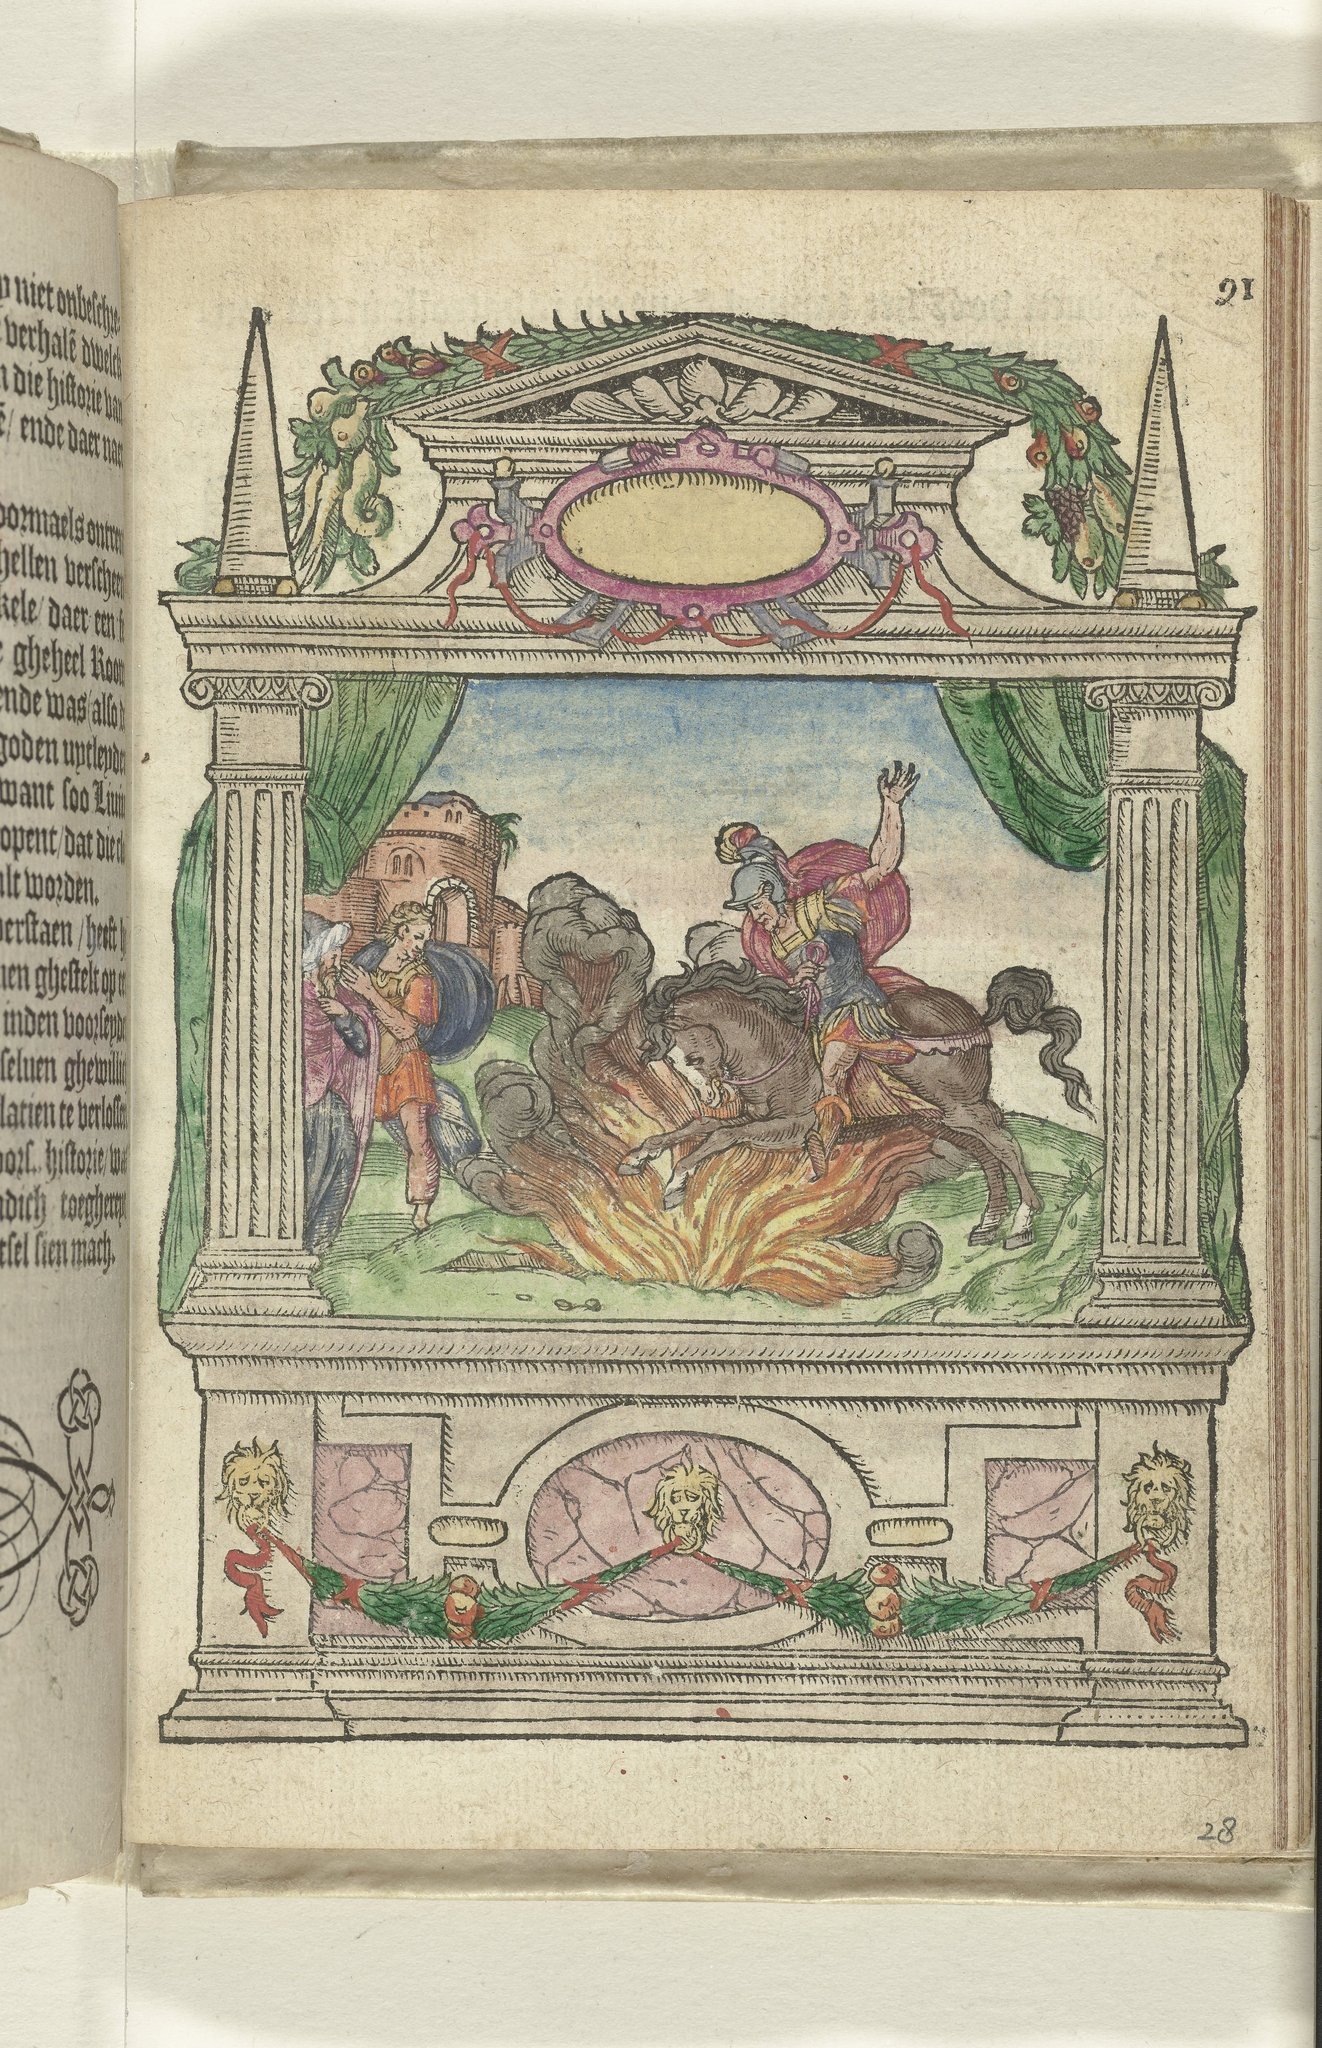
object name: print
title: Toneel met de heldendaad van Marcus Curtius, 1578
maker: antoni van leest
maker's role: print maker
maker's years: 1545-1592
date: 1578-1579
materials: paper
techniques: hand coloring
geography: antwerp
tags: vienna, matthias van oostenrijk (rooms-duits keizer), group of actors, troupe; actors on the stage, triumphal entry and public reception, pageant, 'entrée solennelle', 'joyeuse entrée', death, i.e. the self-sacrifice of marcus (manlius) curtius: he leaps on horseback into a chasm with lethal fumes, brussels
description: Illustratie in: J.B. Houwaert, Sommare beschrijvinghe vade triumphelijcke Incomst van den doorluchtighen ende hooghgheboren /Aerts-hertoge Matthias binnen die Prinelijcke stadt van Brussele, in 't iaer ons Heeren 1578 den XVIII dach Januarij... Gheinventeert ende ghecomponeert deur Jean Baptista Houwaert, Christoffel Plantijn, Antwerpen 1579. Boek in de Rijksmuseum Research Library met signatuur: 327 K 2.